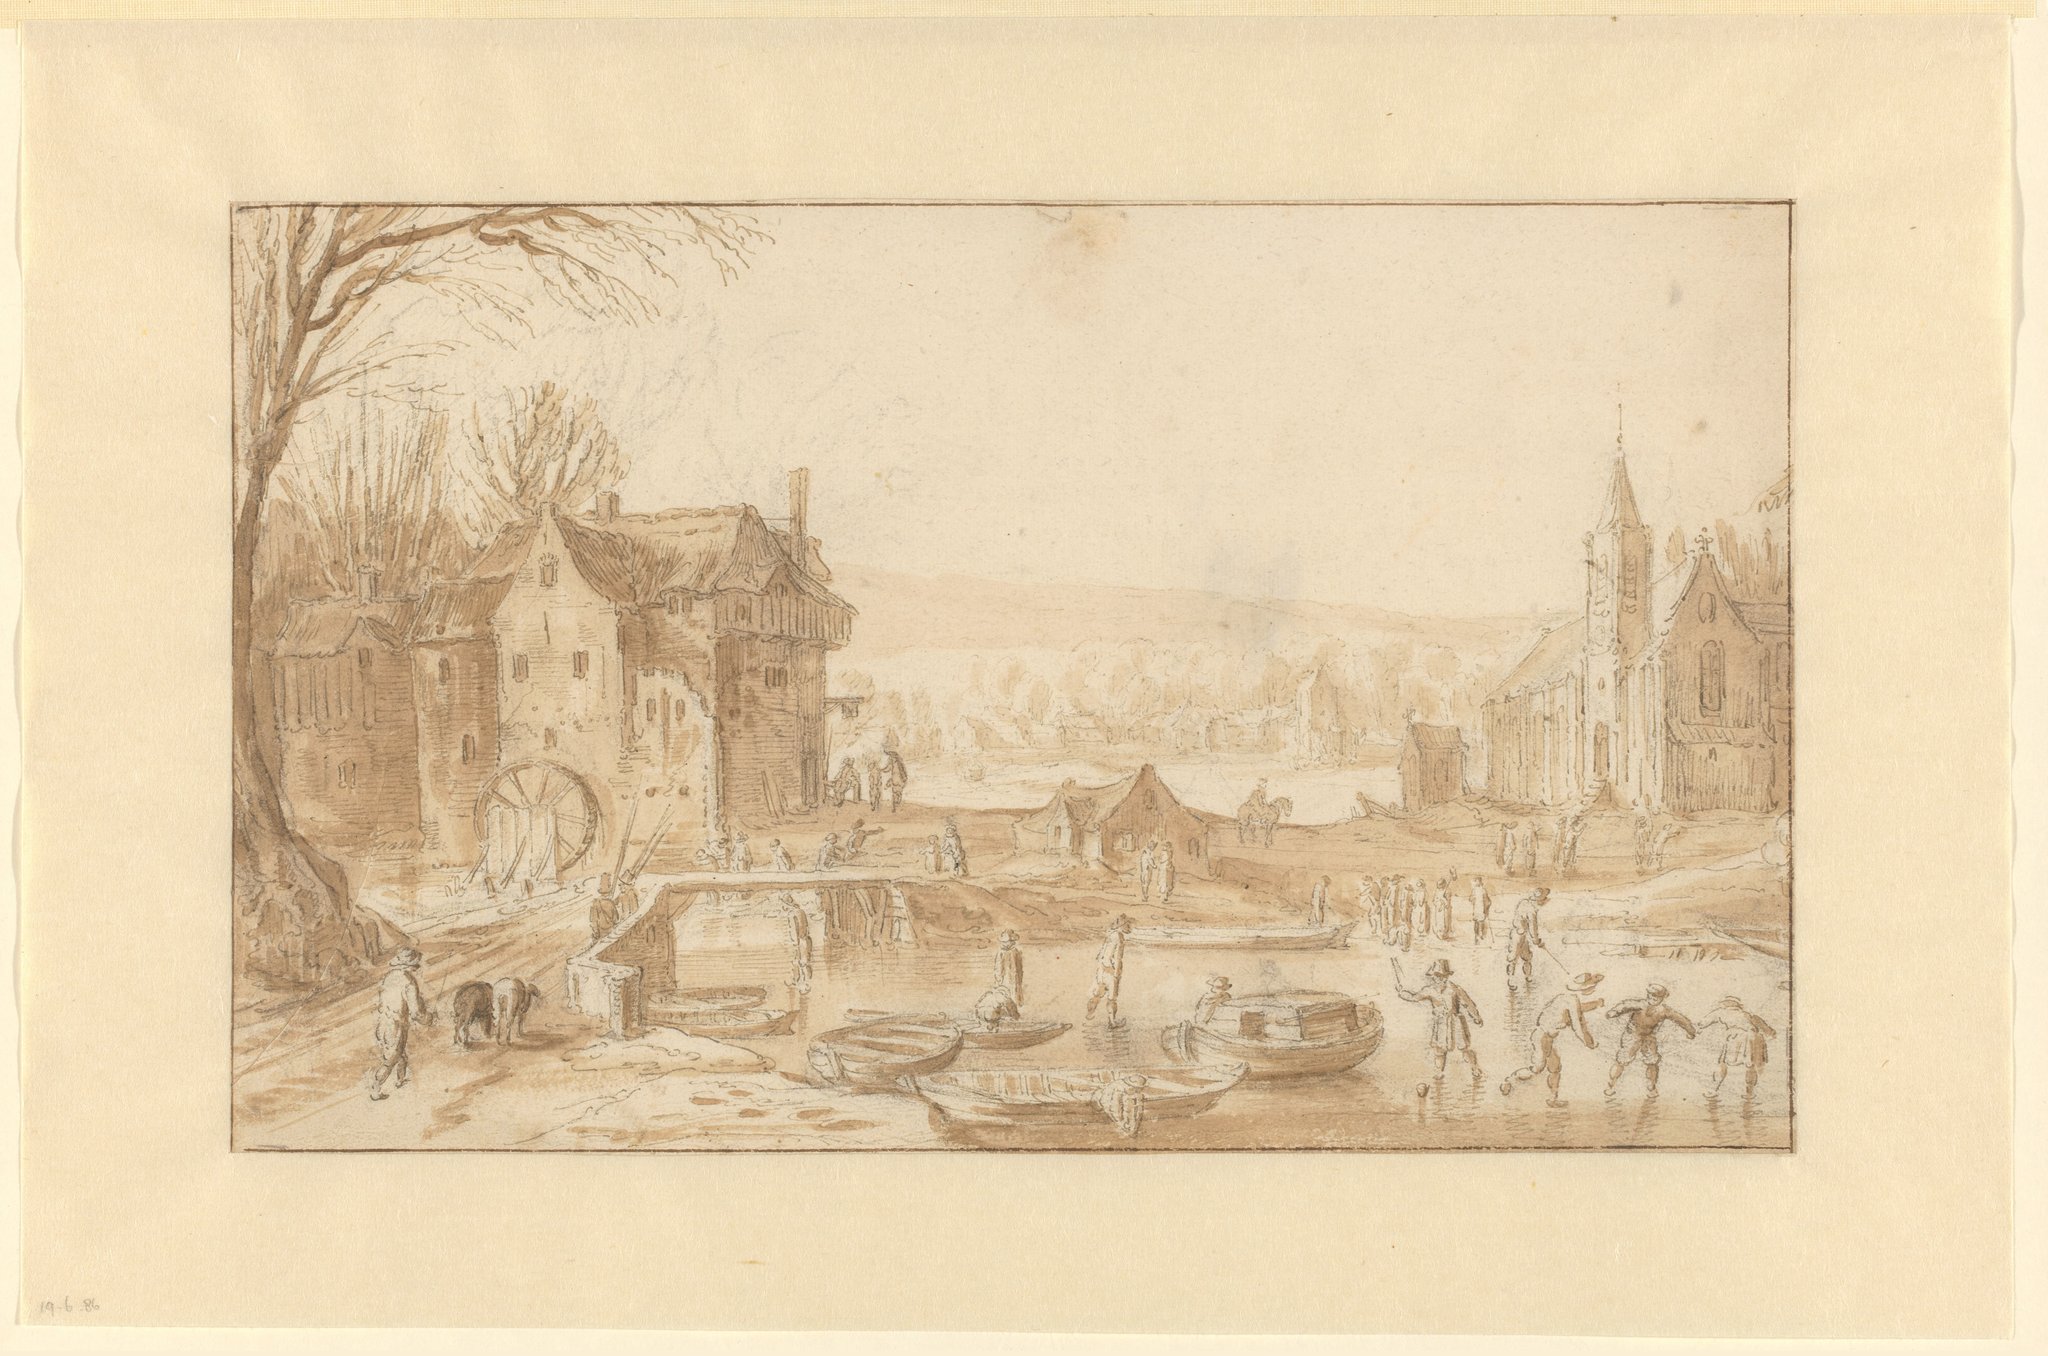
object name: drawing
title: Winterlandschap met ijsvermaak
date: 1640-1676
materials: ink, paper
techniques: brush, pen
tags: square, place, circus, etc., winter sports, church (exterior), ice ~ freezing weather, watermill, hotel, hostelry, inn